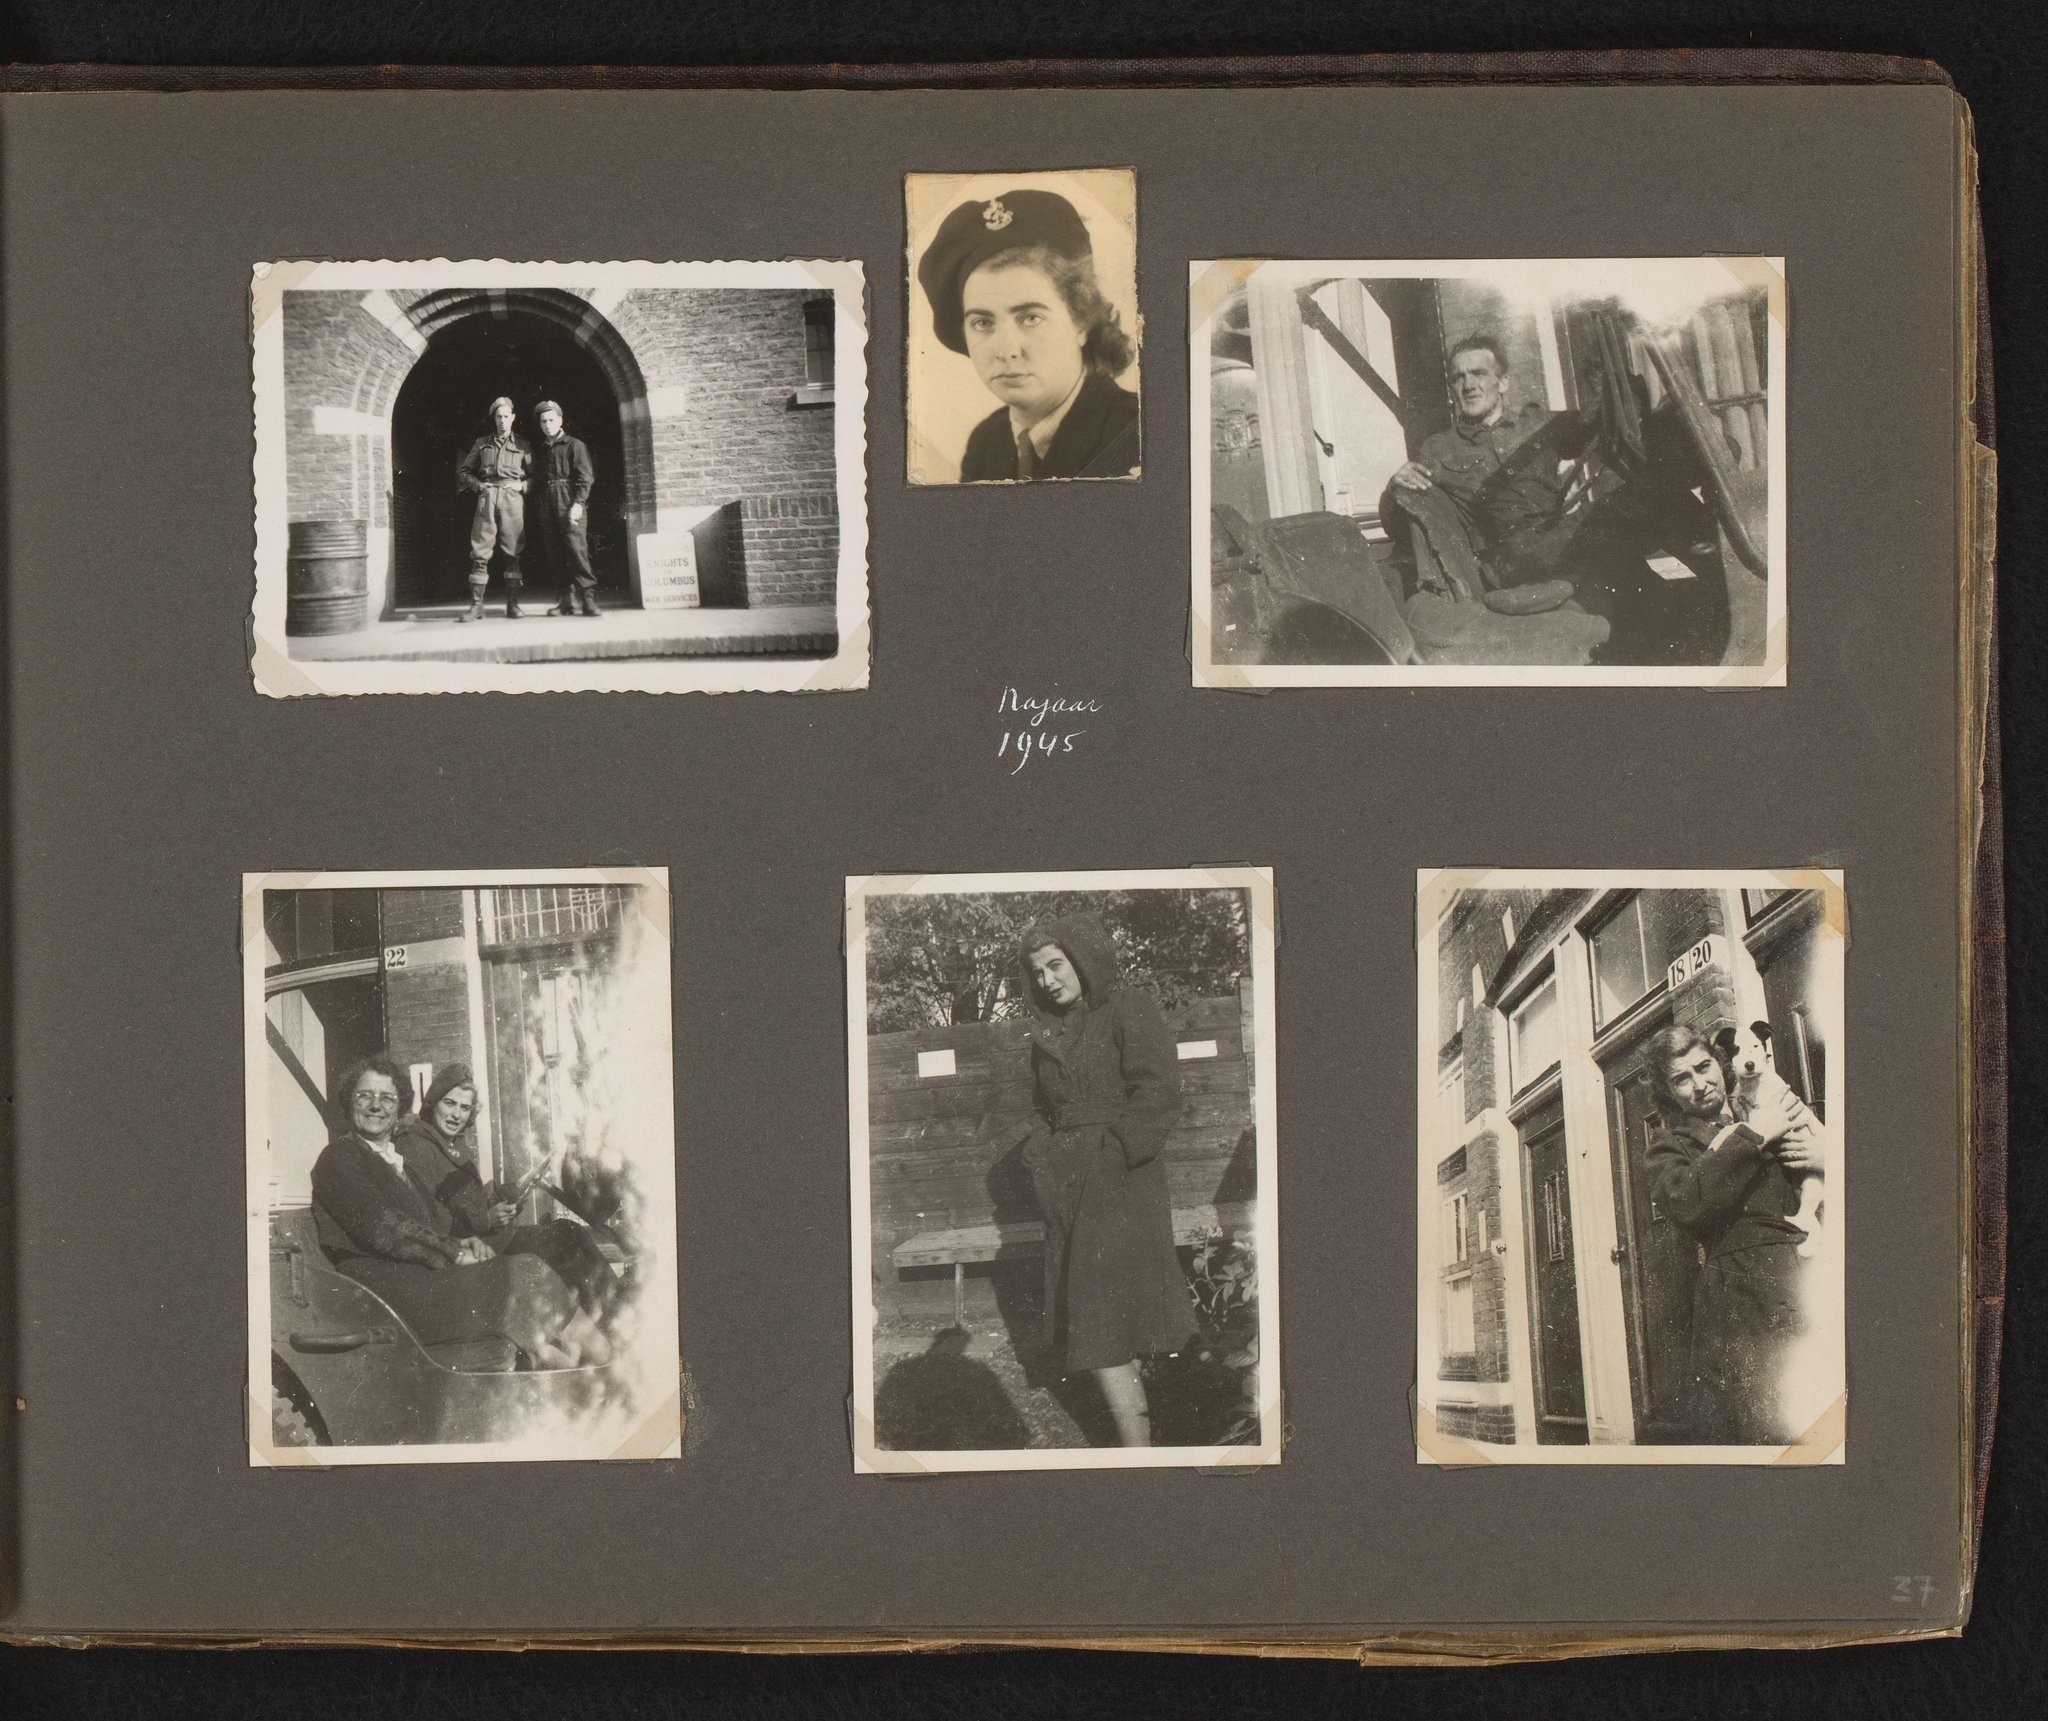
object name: photograph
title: Najaar 1945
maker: Anonymous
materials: paper, photographic support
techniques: gelatin silver print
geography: netherlands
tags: non-combatants ~ war, modern forms of military vehicles (with name), netherlands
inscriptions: inscription: ‘Najaar 1945’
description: Albumblad met zes foto's, o.a. van de geallieerde militair Martin O'Brienn en vrouwen poserend achter de stuur van een jeep, najaar 1945, Onderdeel van het Familiealbum 1940-1947.